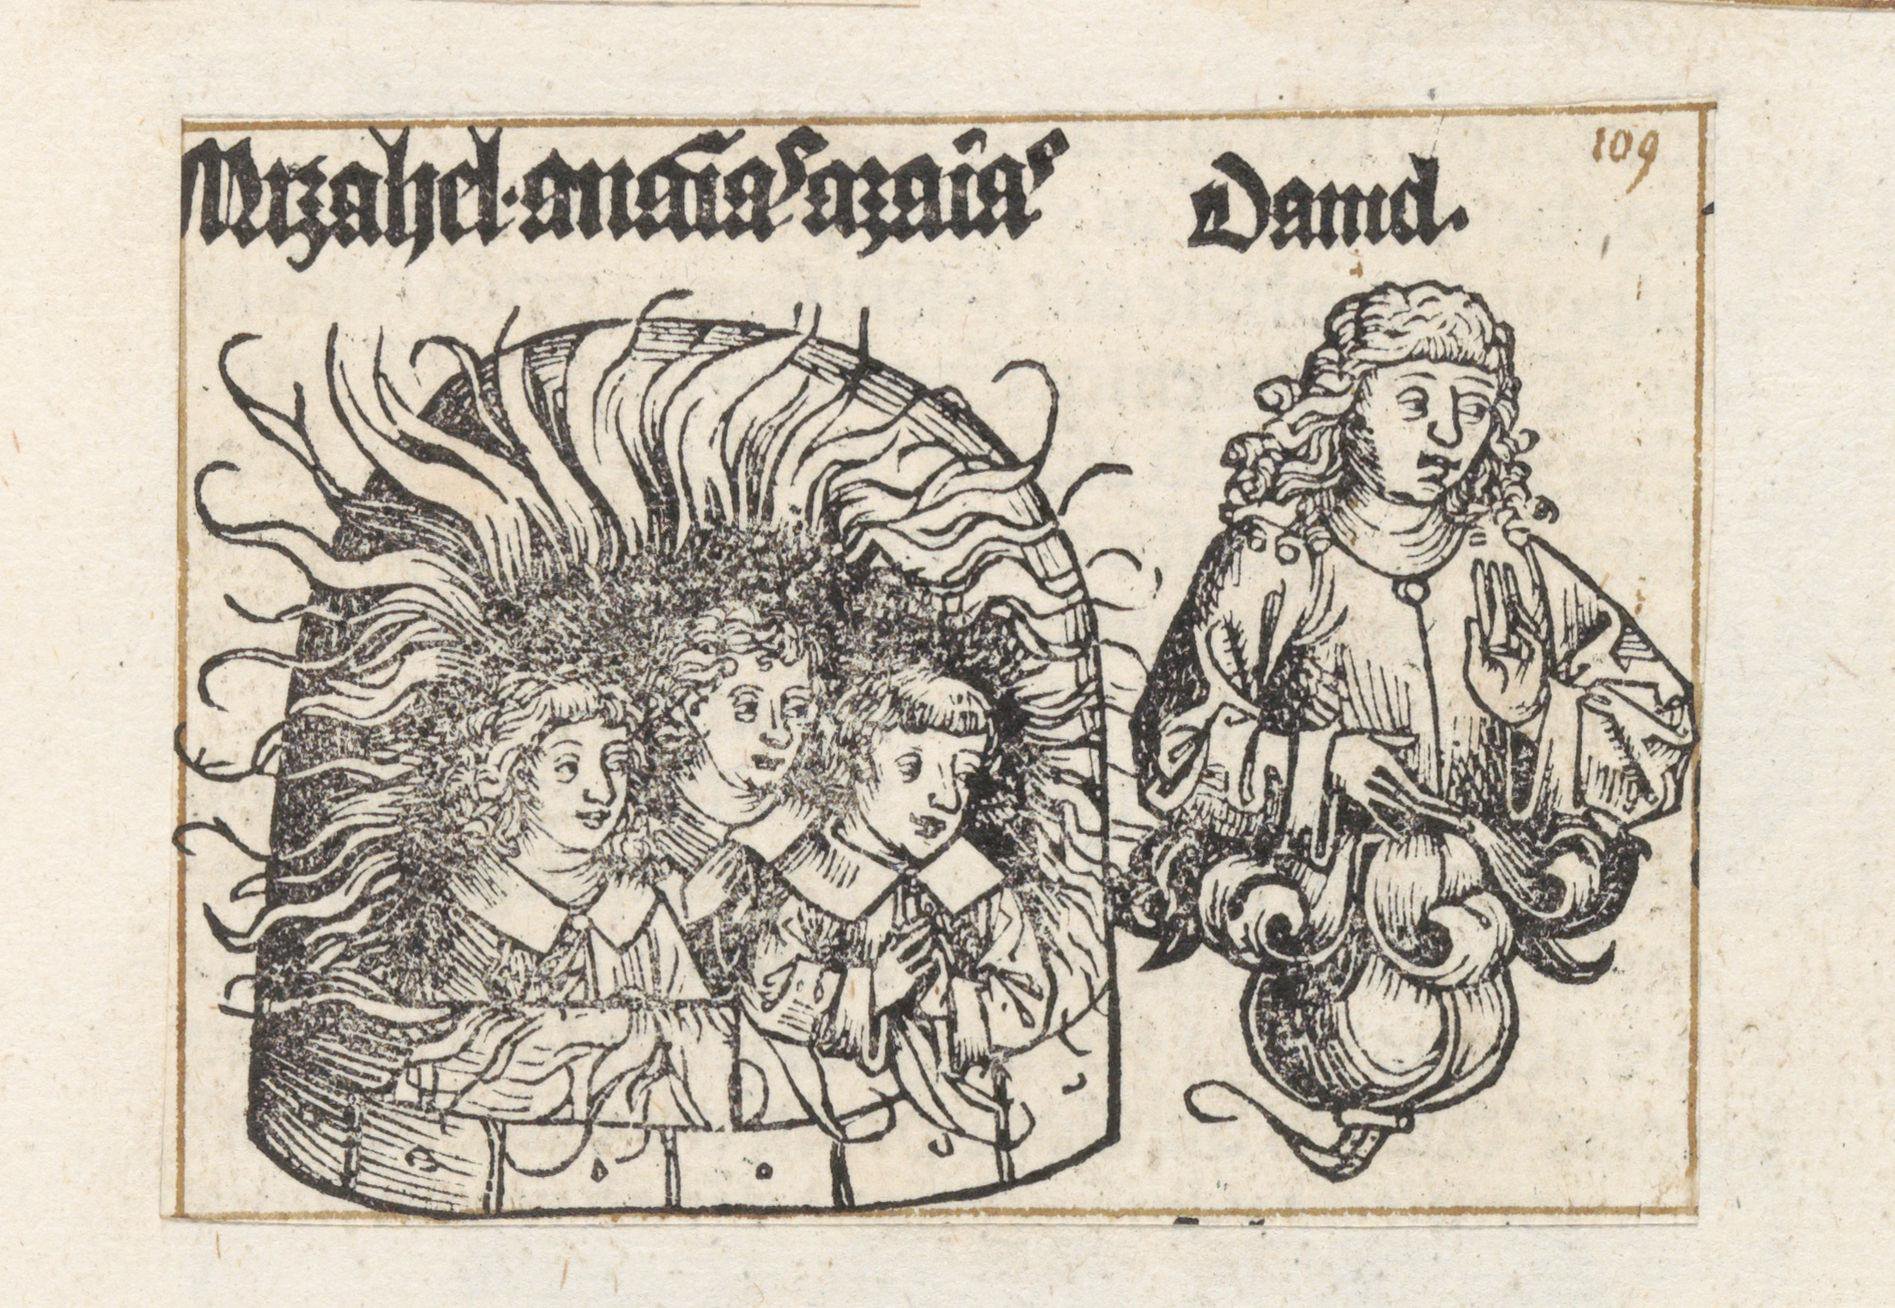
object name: print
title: Drie mannen in de vuuroven en Daniël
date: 1493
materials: paper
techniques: letterpress printing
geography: nuremberg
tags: the story of the three hebrews in the fiery furnace (daniel 3)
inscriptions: inscription: ‘109’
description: Drie jongelingen in een oven (Misaël, Ananias en Azarias). Zij werden door Nebukadnessar in de oven geworpen omdat ze weigerden een gouden beeld te aanbidden. Daarnaast een bloemkelk met een man, naar rechts kijkend. De tekst identificeert hem als de profeet Daniël. De prent maakt deel uit van een album.